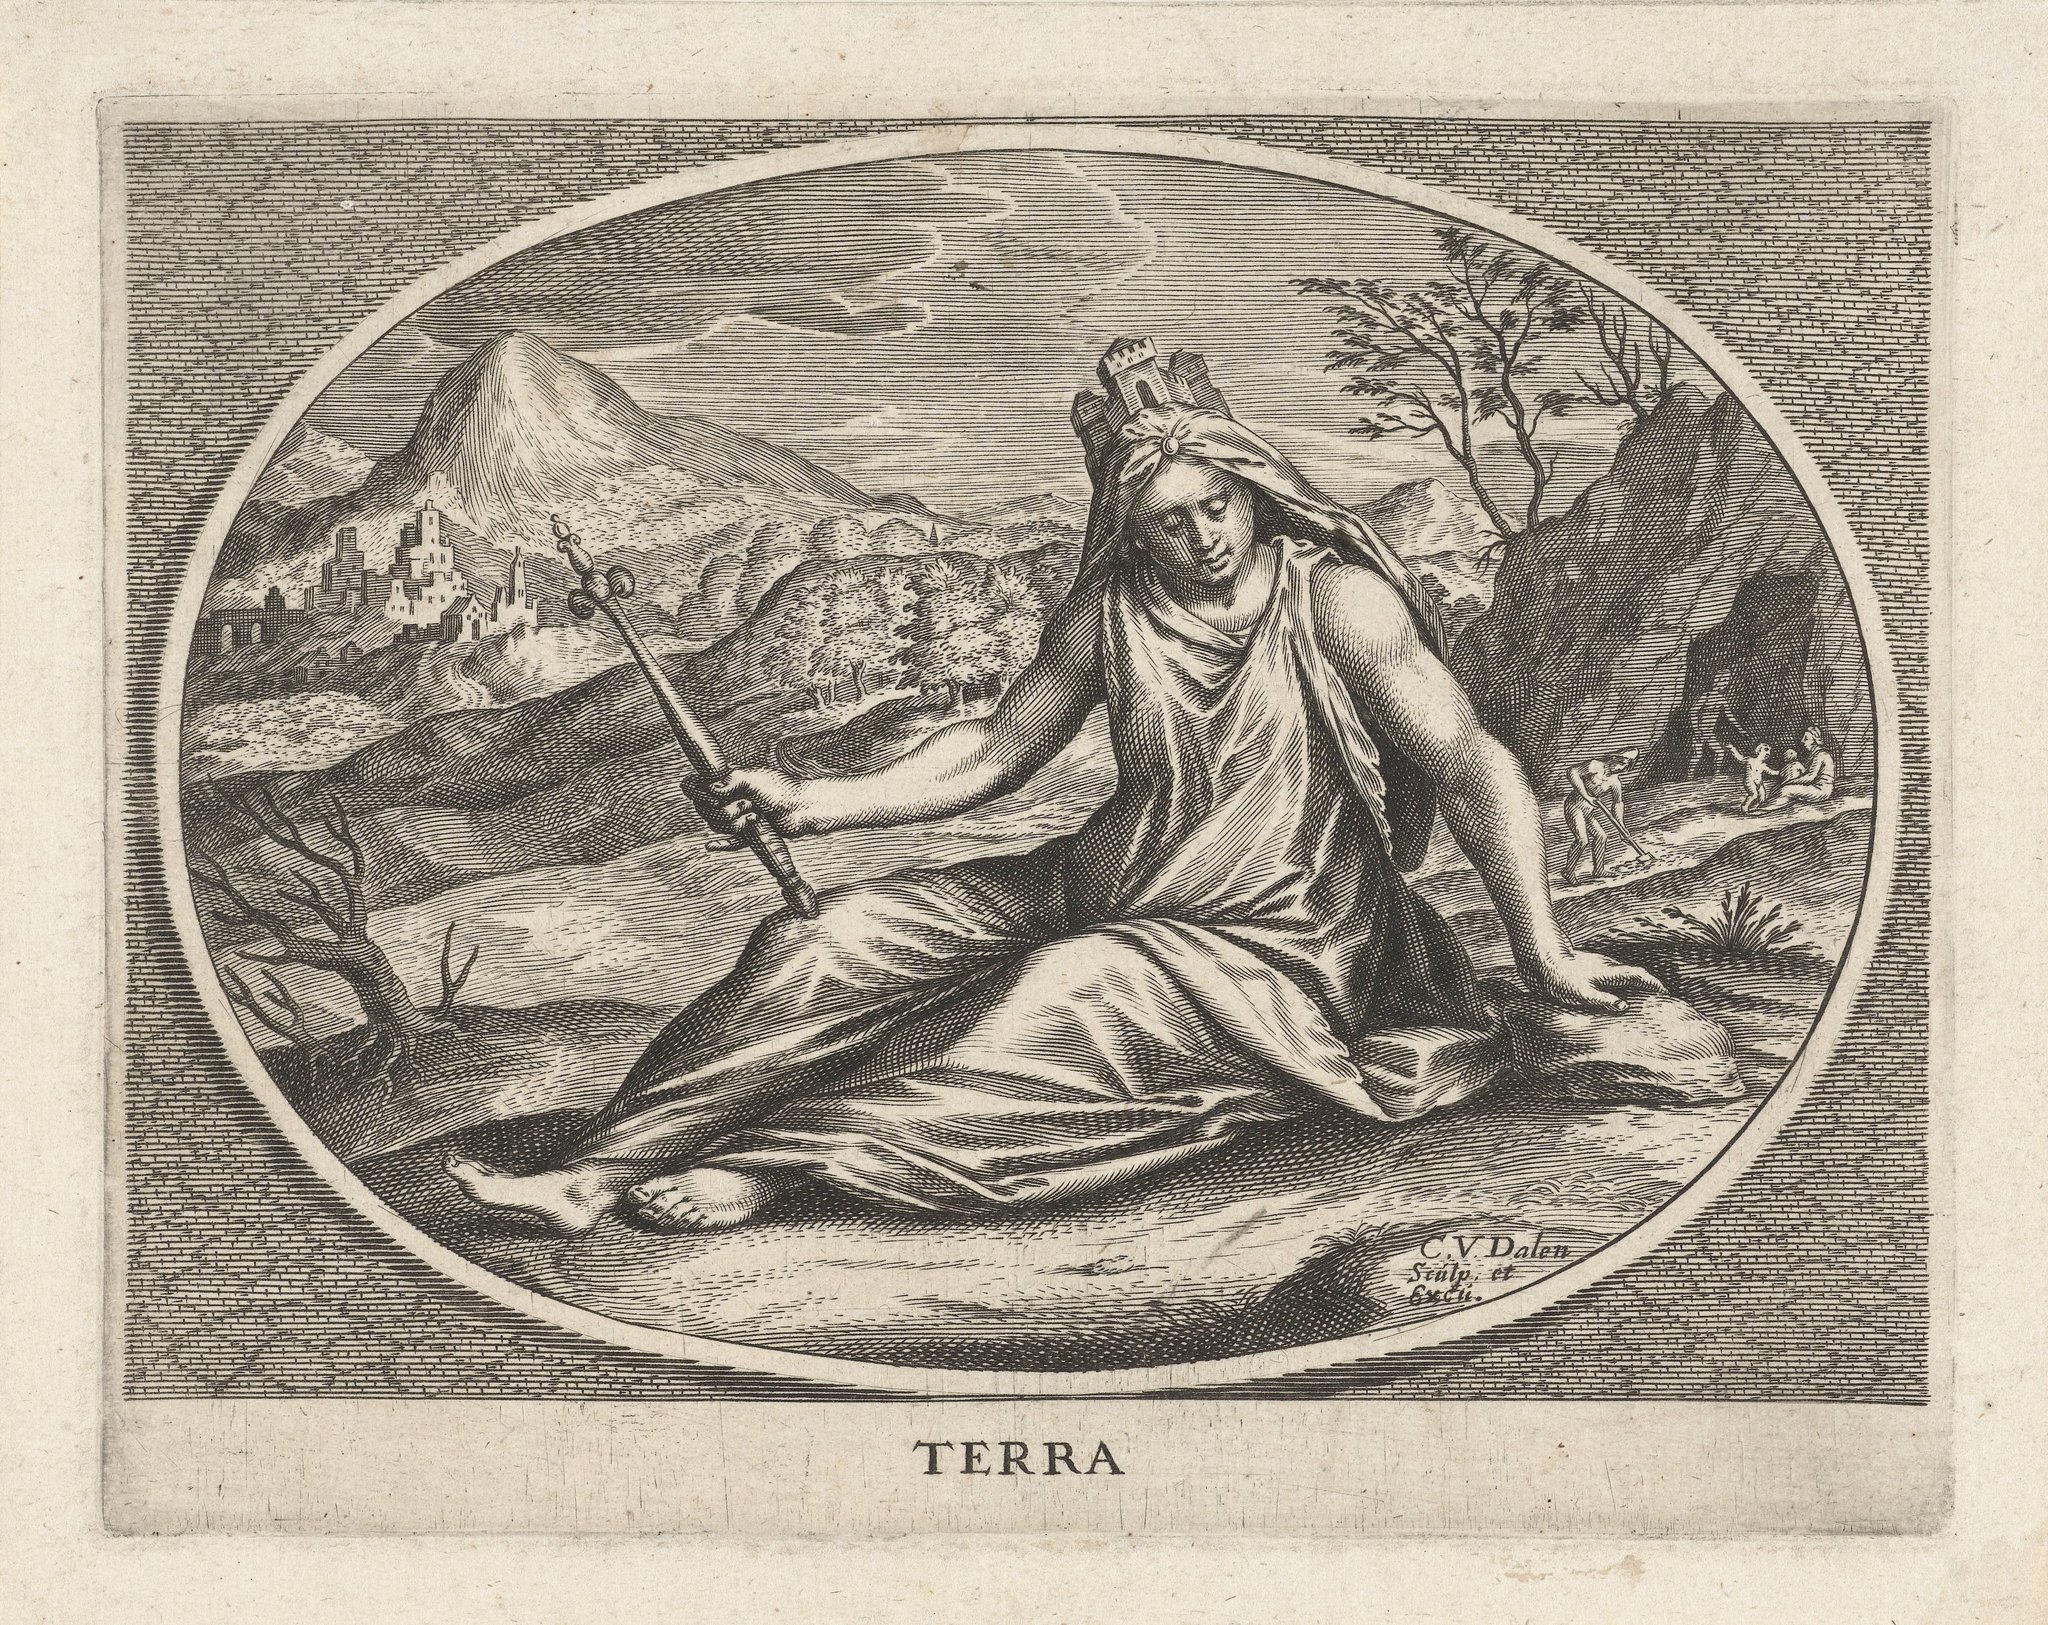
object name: print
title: Vrouwelijke personificatie van element aarde met muurkroon en scepter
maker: cornelis van dalen (ii)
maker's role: draughtsman, print maker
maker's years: 1638-1664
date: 1648-1664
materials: paper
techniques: engraving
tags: earth (one of the four elements)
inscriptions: collector's mark: Lugt 2228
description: Prent mogelijk naar ontwerp van Dirck Barendsz. aldus opmerking verso.